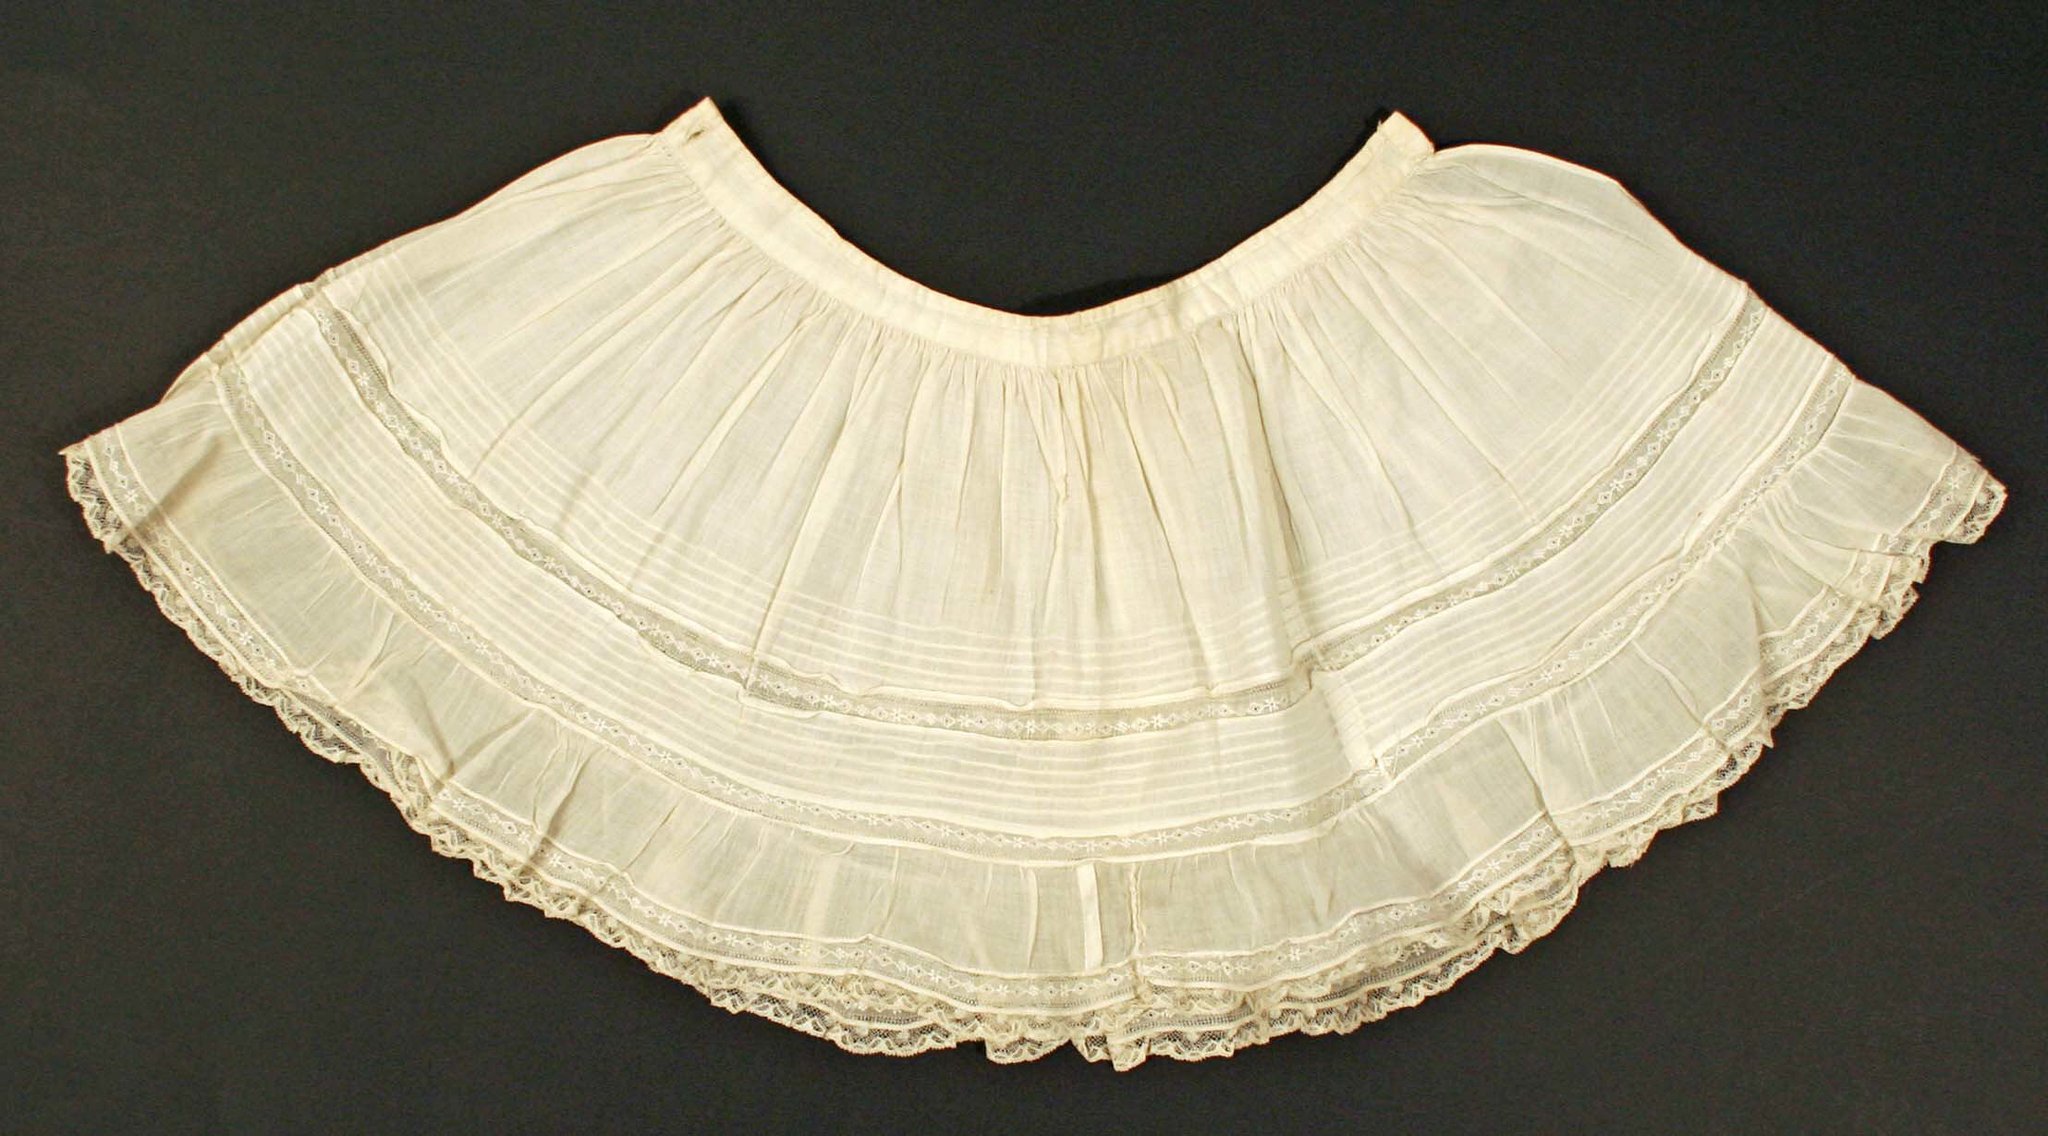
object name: petticoat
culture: american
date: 1903